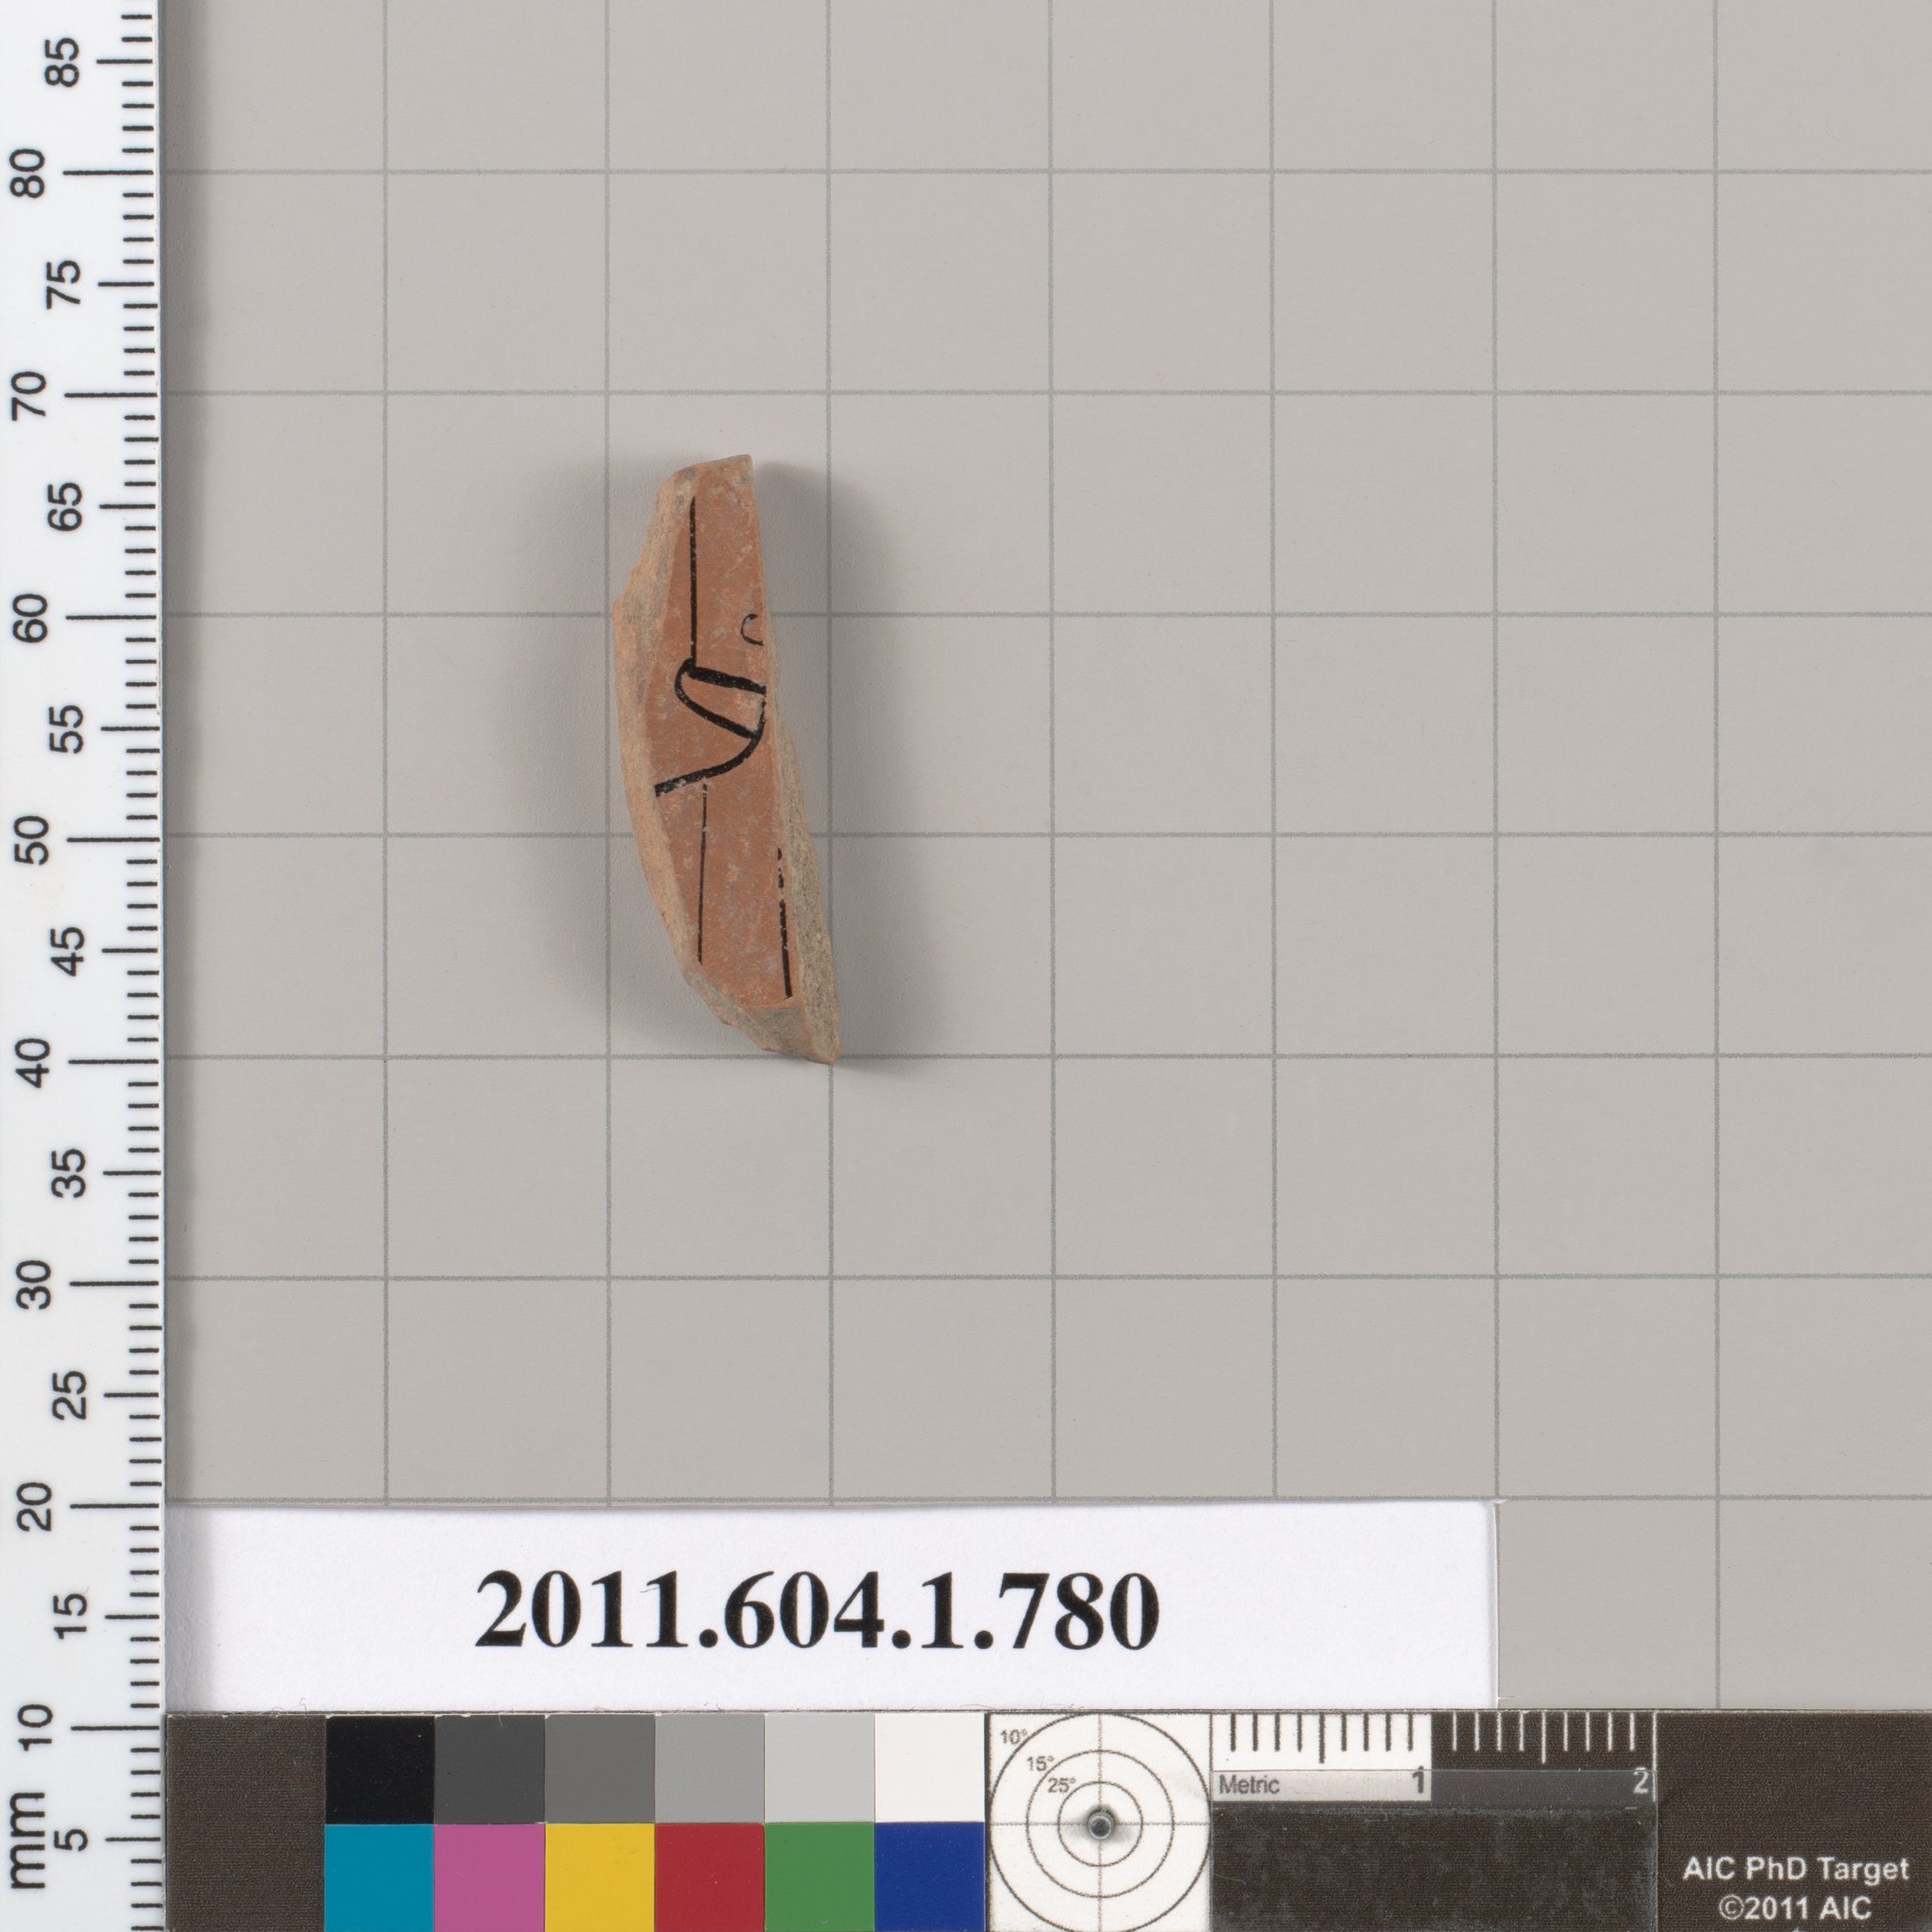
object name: kylix fragment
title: Terracotta fragment of a kylix (drinking cup)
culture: greek, attic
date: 475-451 BCE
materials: terracotta